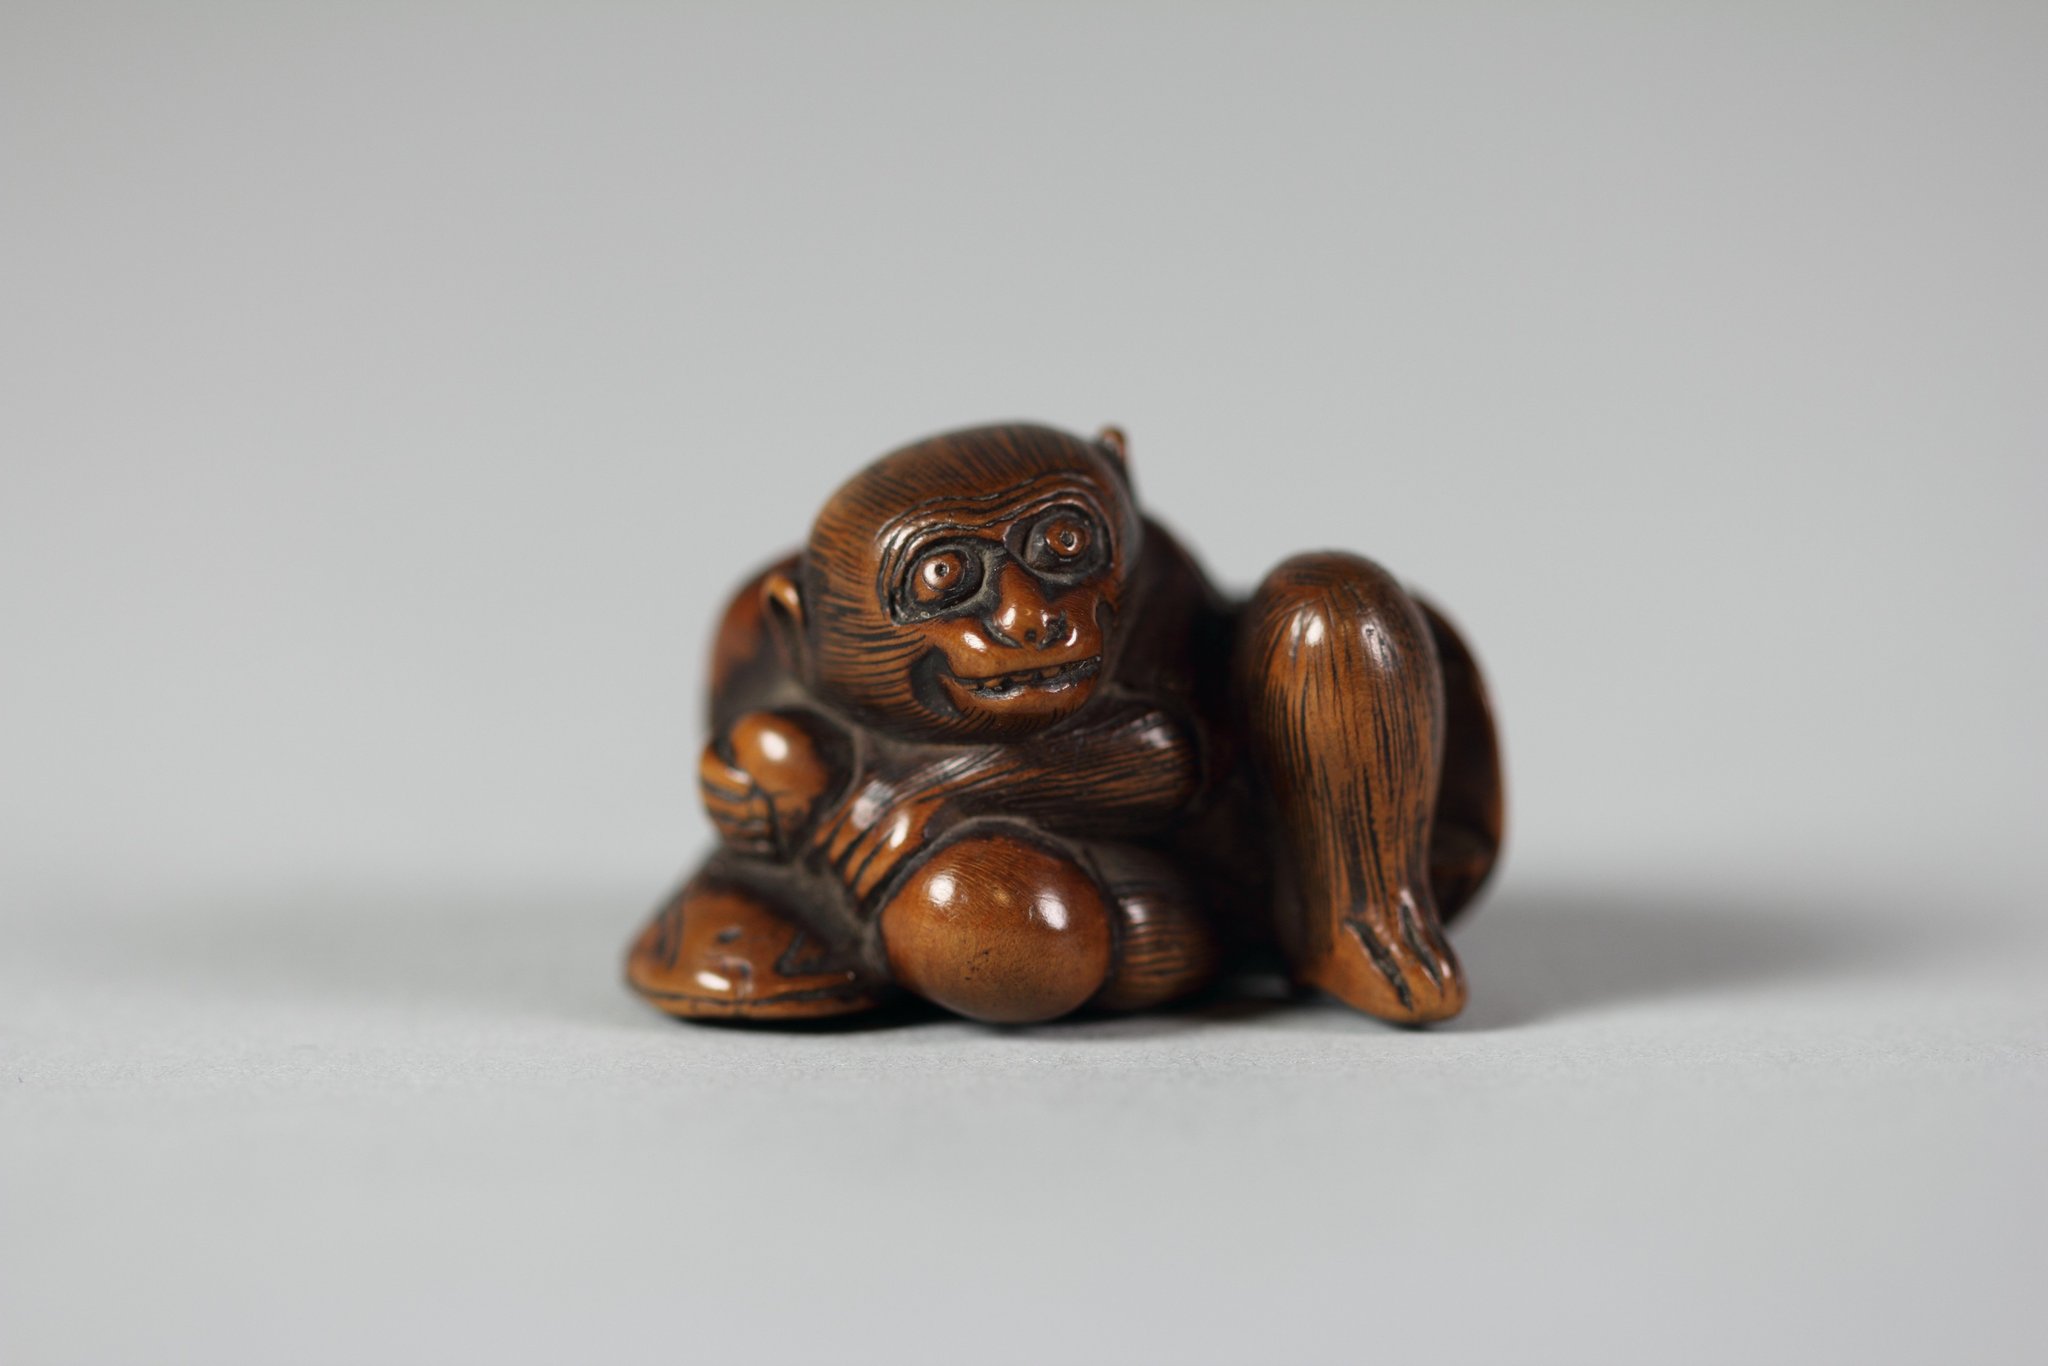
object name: netsuke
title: Netsuke of Monkey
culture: japanese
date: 1701-1800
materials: wood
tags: monkeys